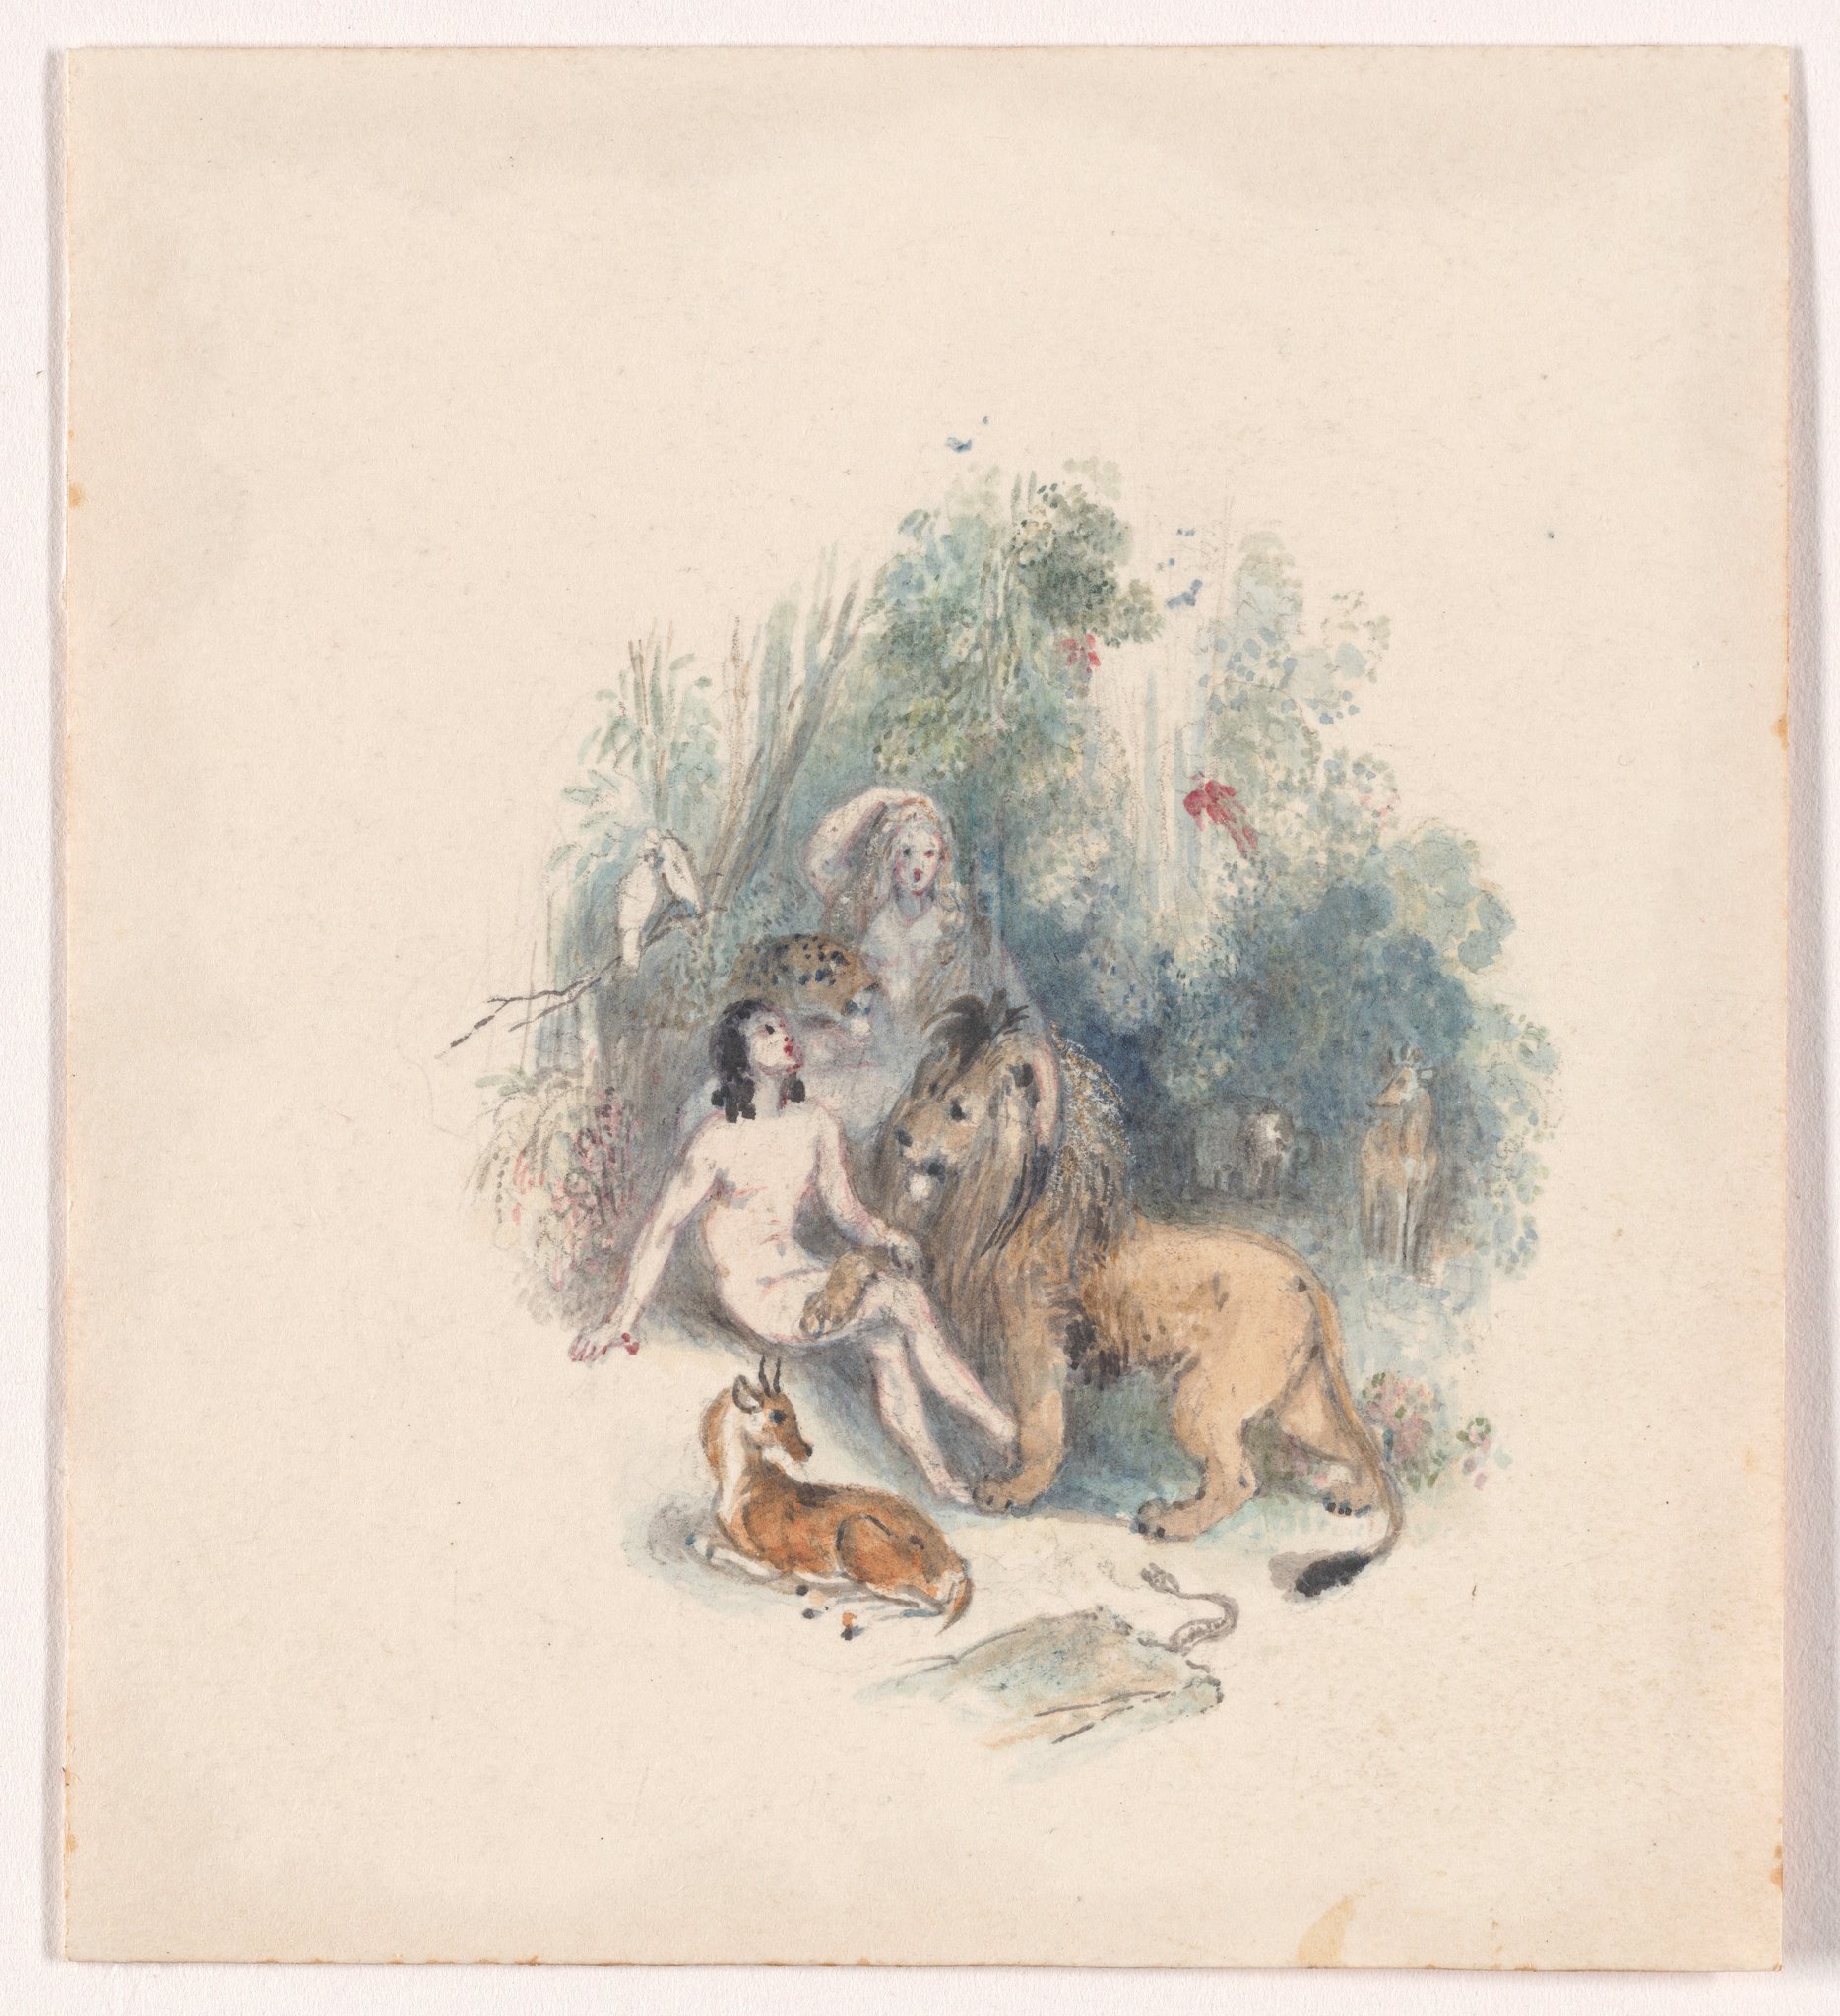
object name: drawing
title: Illustration design for "The Economy of Human Life"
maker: frank howard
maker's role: artist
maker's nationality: british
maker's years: 1805-1866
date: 1834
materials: watercolor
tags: men,women,deer,lions